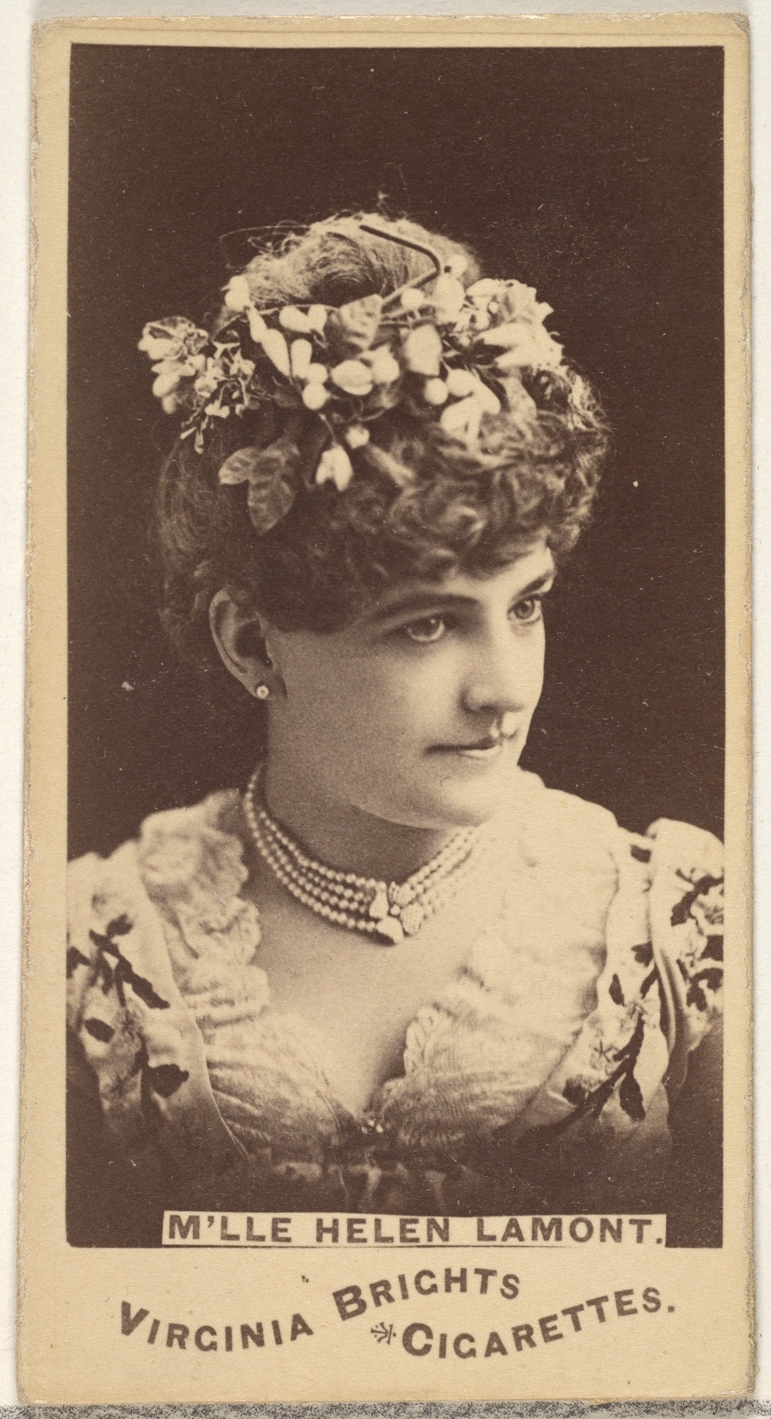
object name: photograph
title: Mlle. Helen Lamont, from the Actors and Actresses series (N45, Type 1) for Virginia Brights Cigarettes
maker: allen & ginter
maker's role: publisher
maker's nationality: american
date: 1888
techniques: albumen silver print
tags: portraits,women,actresses